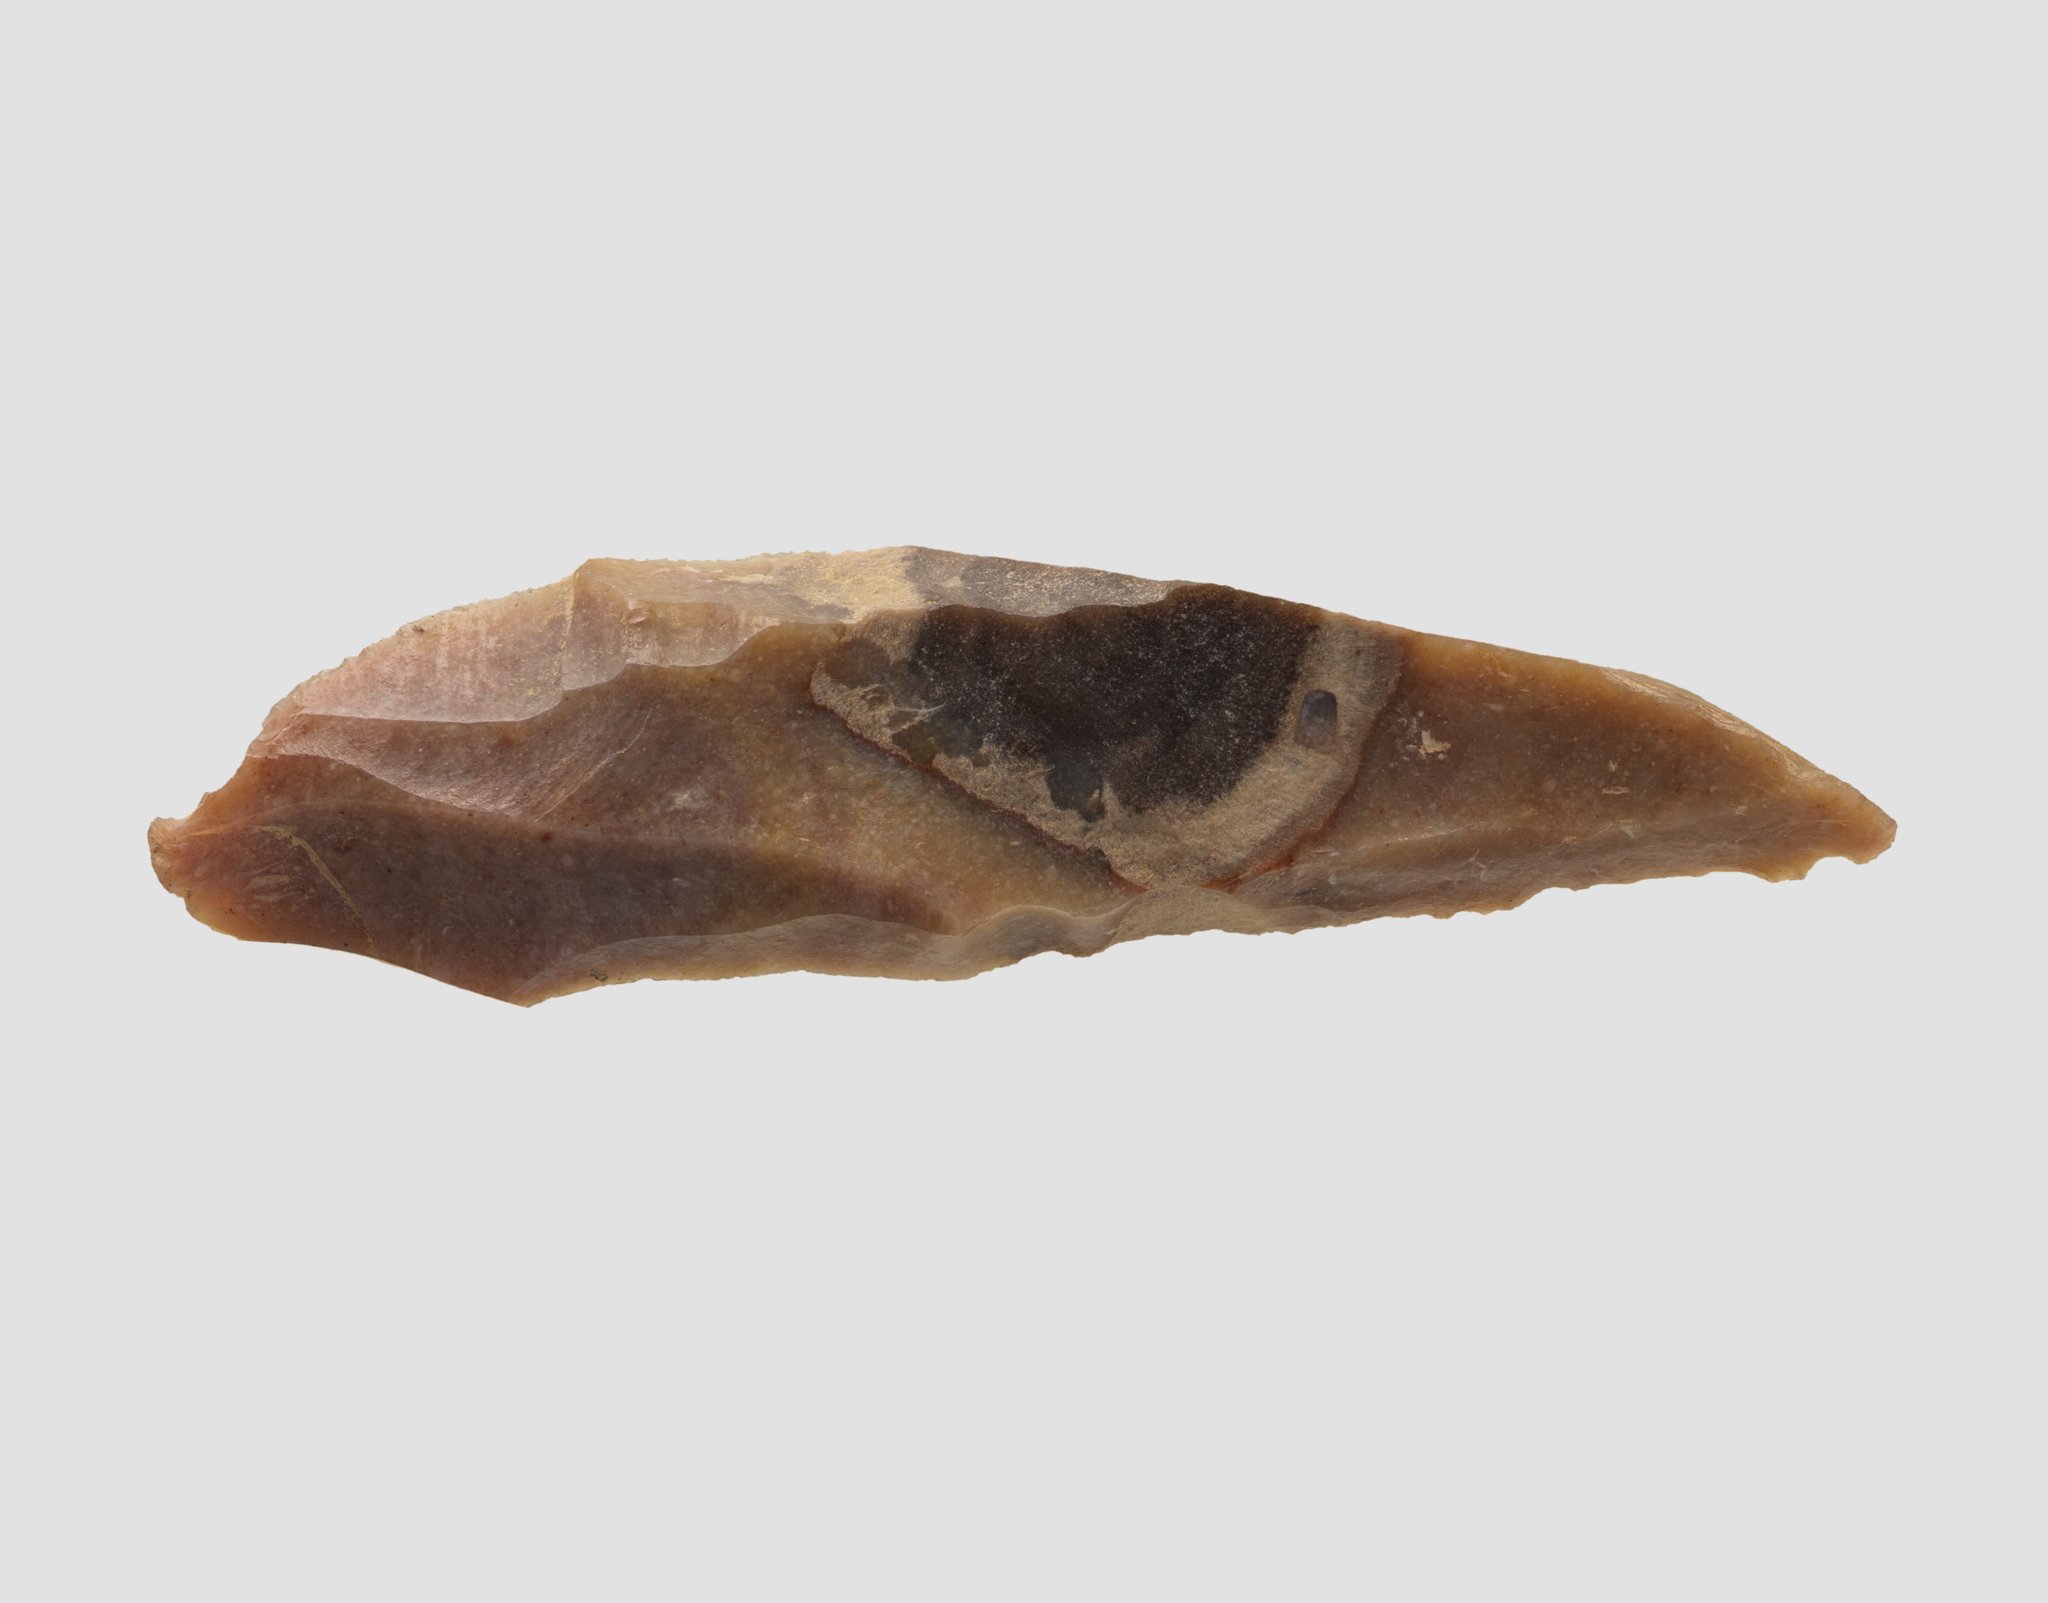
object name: knife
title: Blade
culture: ghassulian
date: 4600-3600 BCE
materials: stone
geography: levant